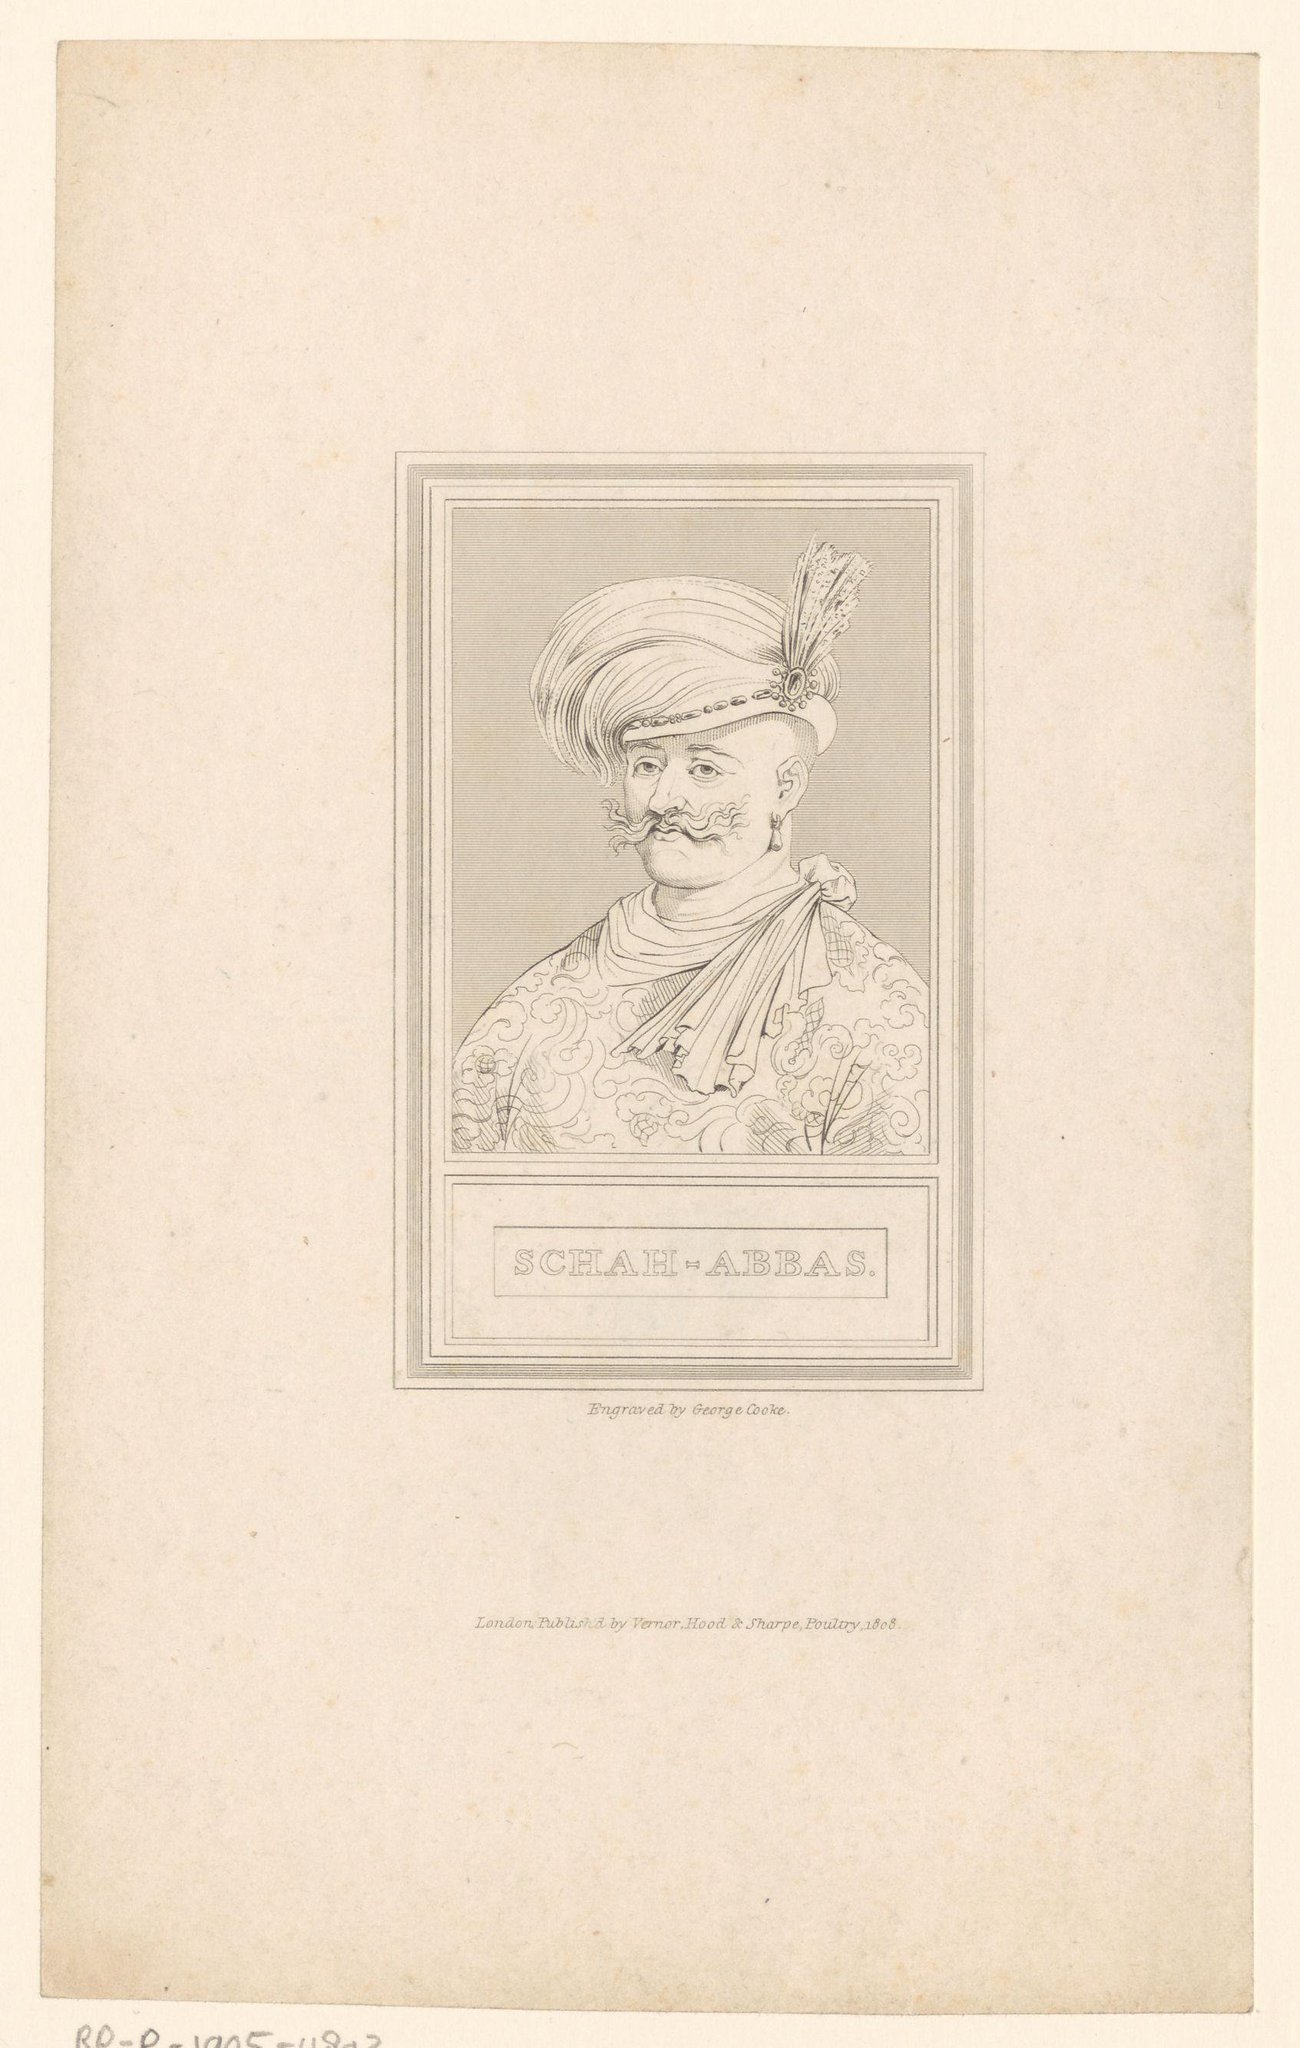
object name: book illustration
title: Schah-Abbas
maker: george cooke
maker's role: print maker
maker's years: 1781-1834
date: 1808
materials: paper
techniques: etching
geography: london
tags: historical persons, ruler, sovereign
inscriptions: collector's mark: Lugt 2228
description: Prent uit: The Historic Gallery of Portraits and Paintings (...). Londen: Vernor, Hood & Sharpe, 1808, dl. 3.